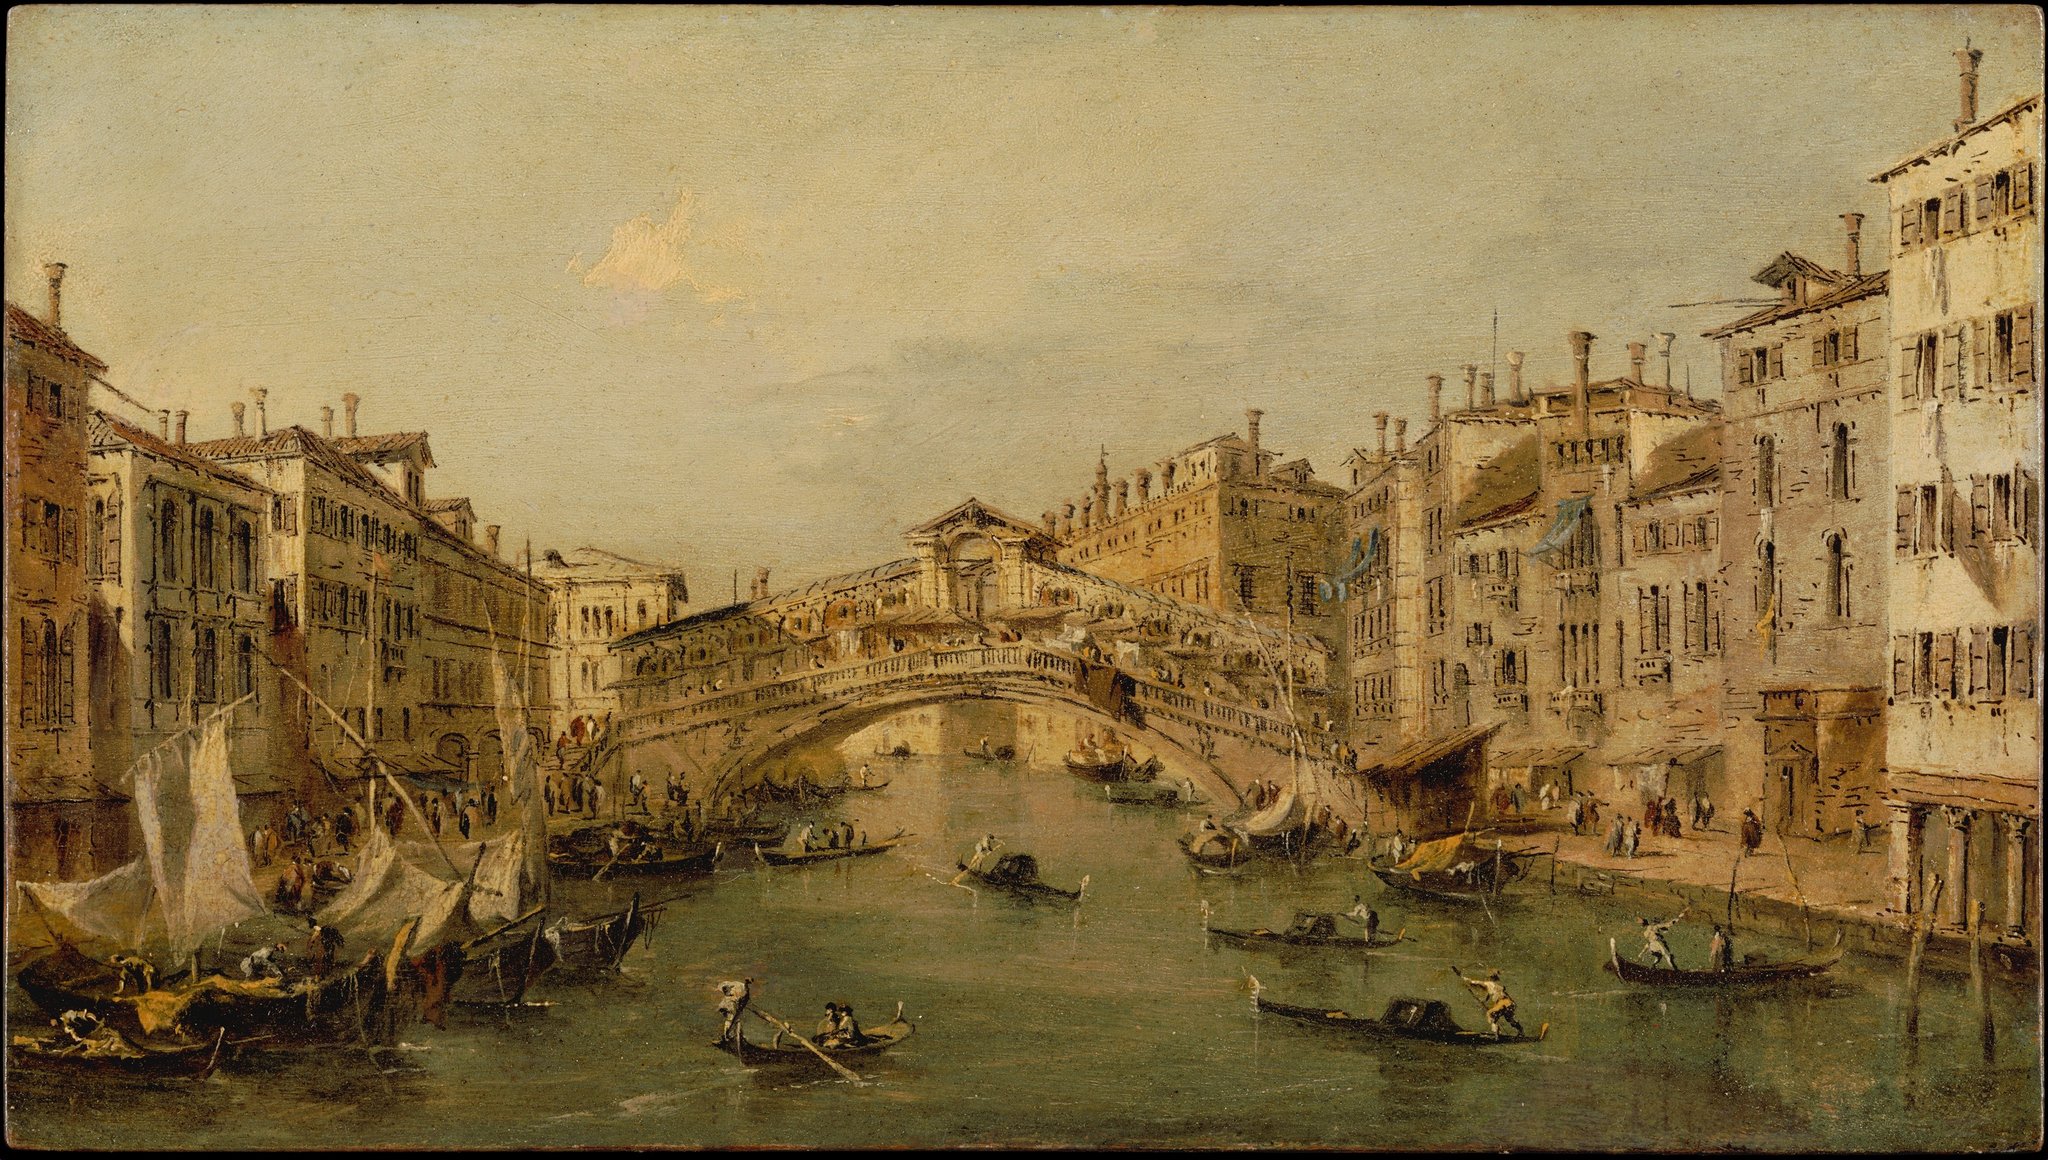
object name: painting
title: Venice: The Rialto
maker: francesco guardi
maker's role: artist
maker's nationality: italian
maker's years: 1712-1793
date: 1732-1793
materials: oil, wood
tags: buildings,cities,canals,rivers,boats,venice